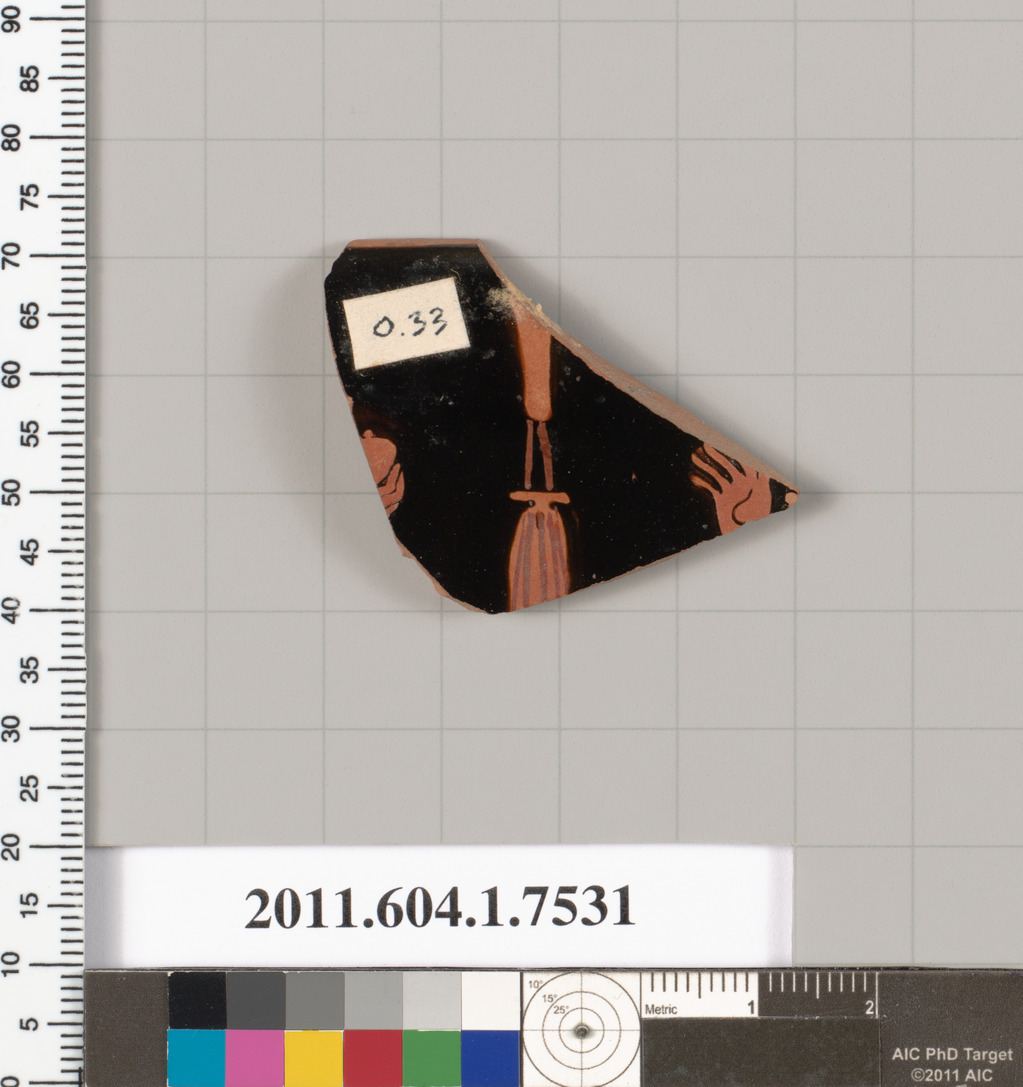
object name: kylix fragment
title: Terracotta rim fragment of a kylix (drinking cup)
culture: greek, attic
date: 460-450 BCE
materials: terracotta